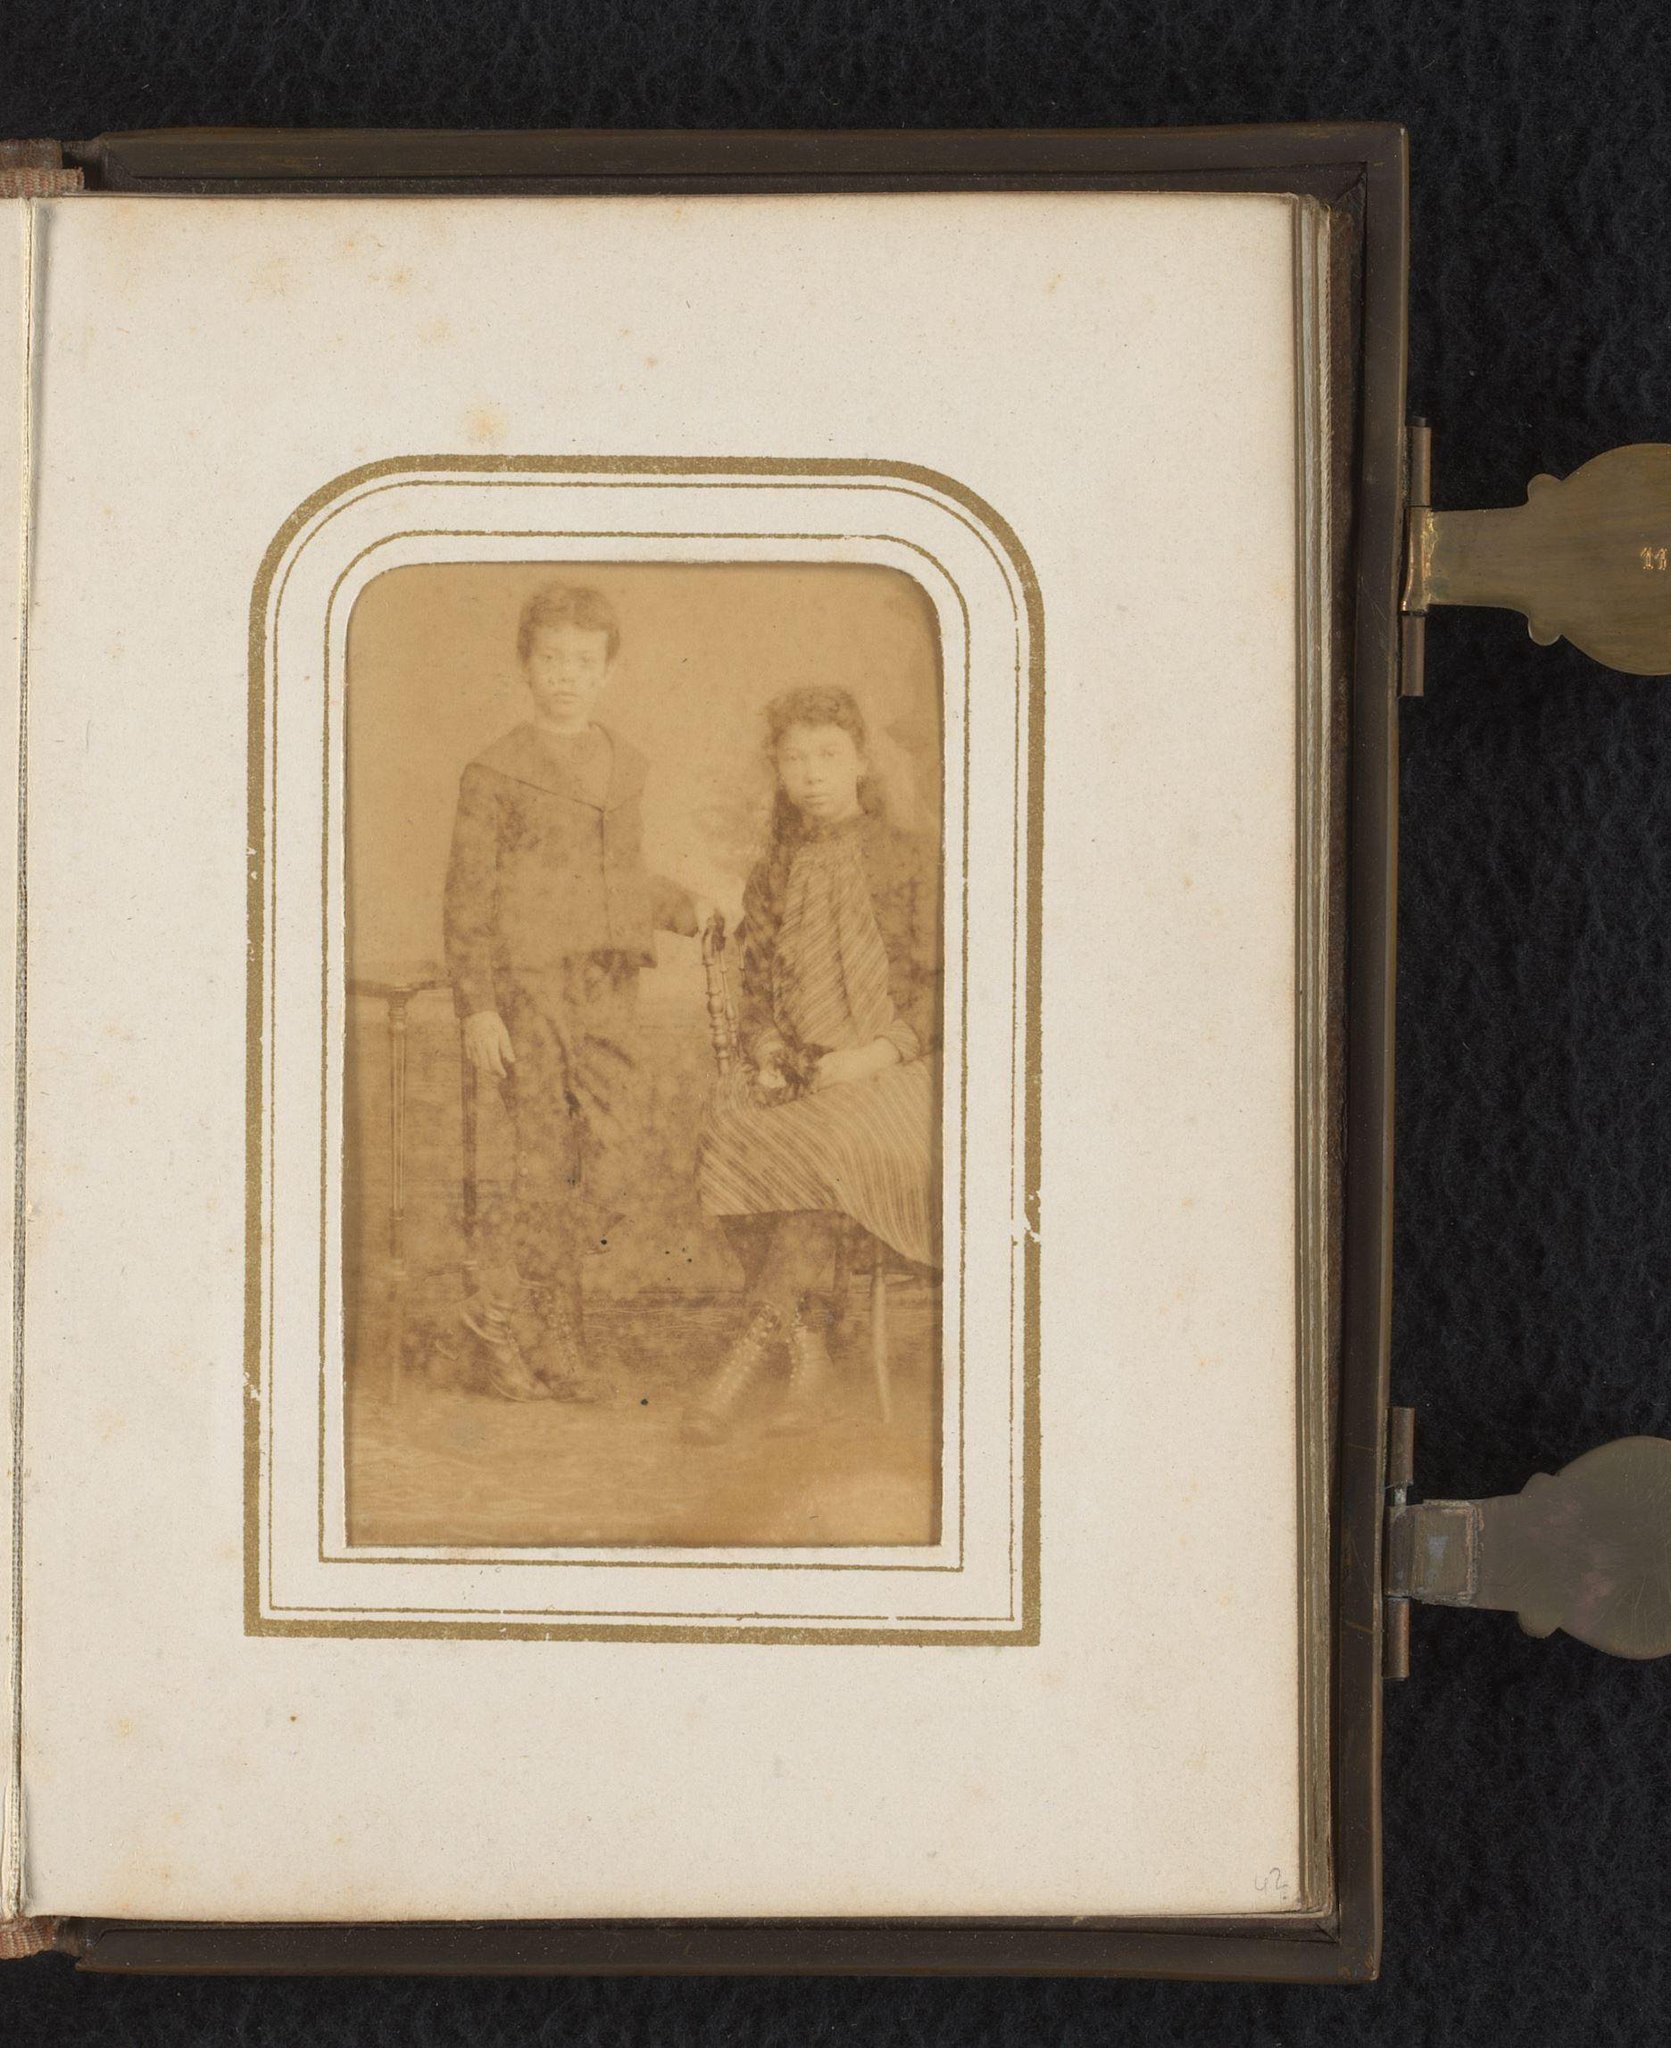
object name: carte de visite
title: Portret van een jongen en meisje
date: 1885-1899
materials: cardboard, photographic support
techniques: albumen print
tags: boy (child between toddler and youth), historical persons, girl (child between toddler and youth)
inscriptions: inscription: ‘Photographisch Artistisches Atelier/ Herrmann & Co/ Batavia/ Ryswyk/ (Ost-Indië)’